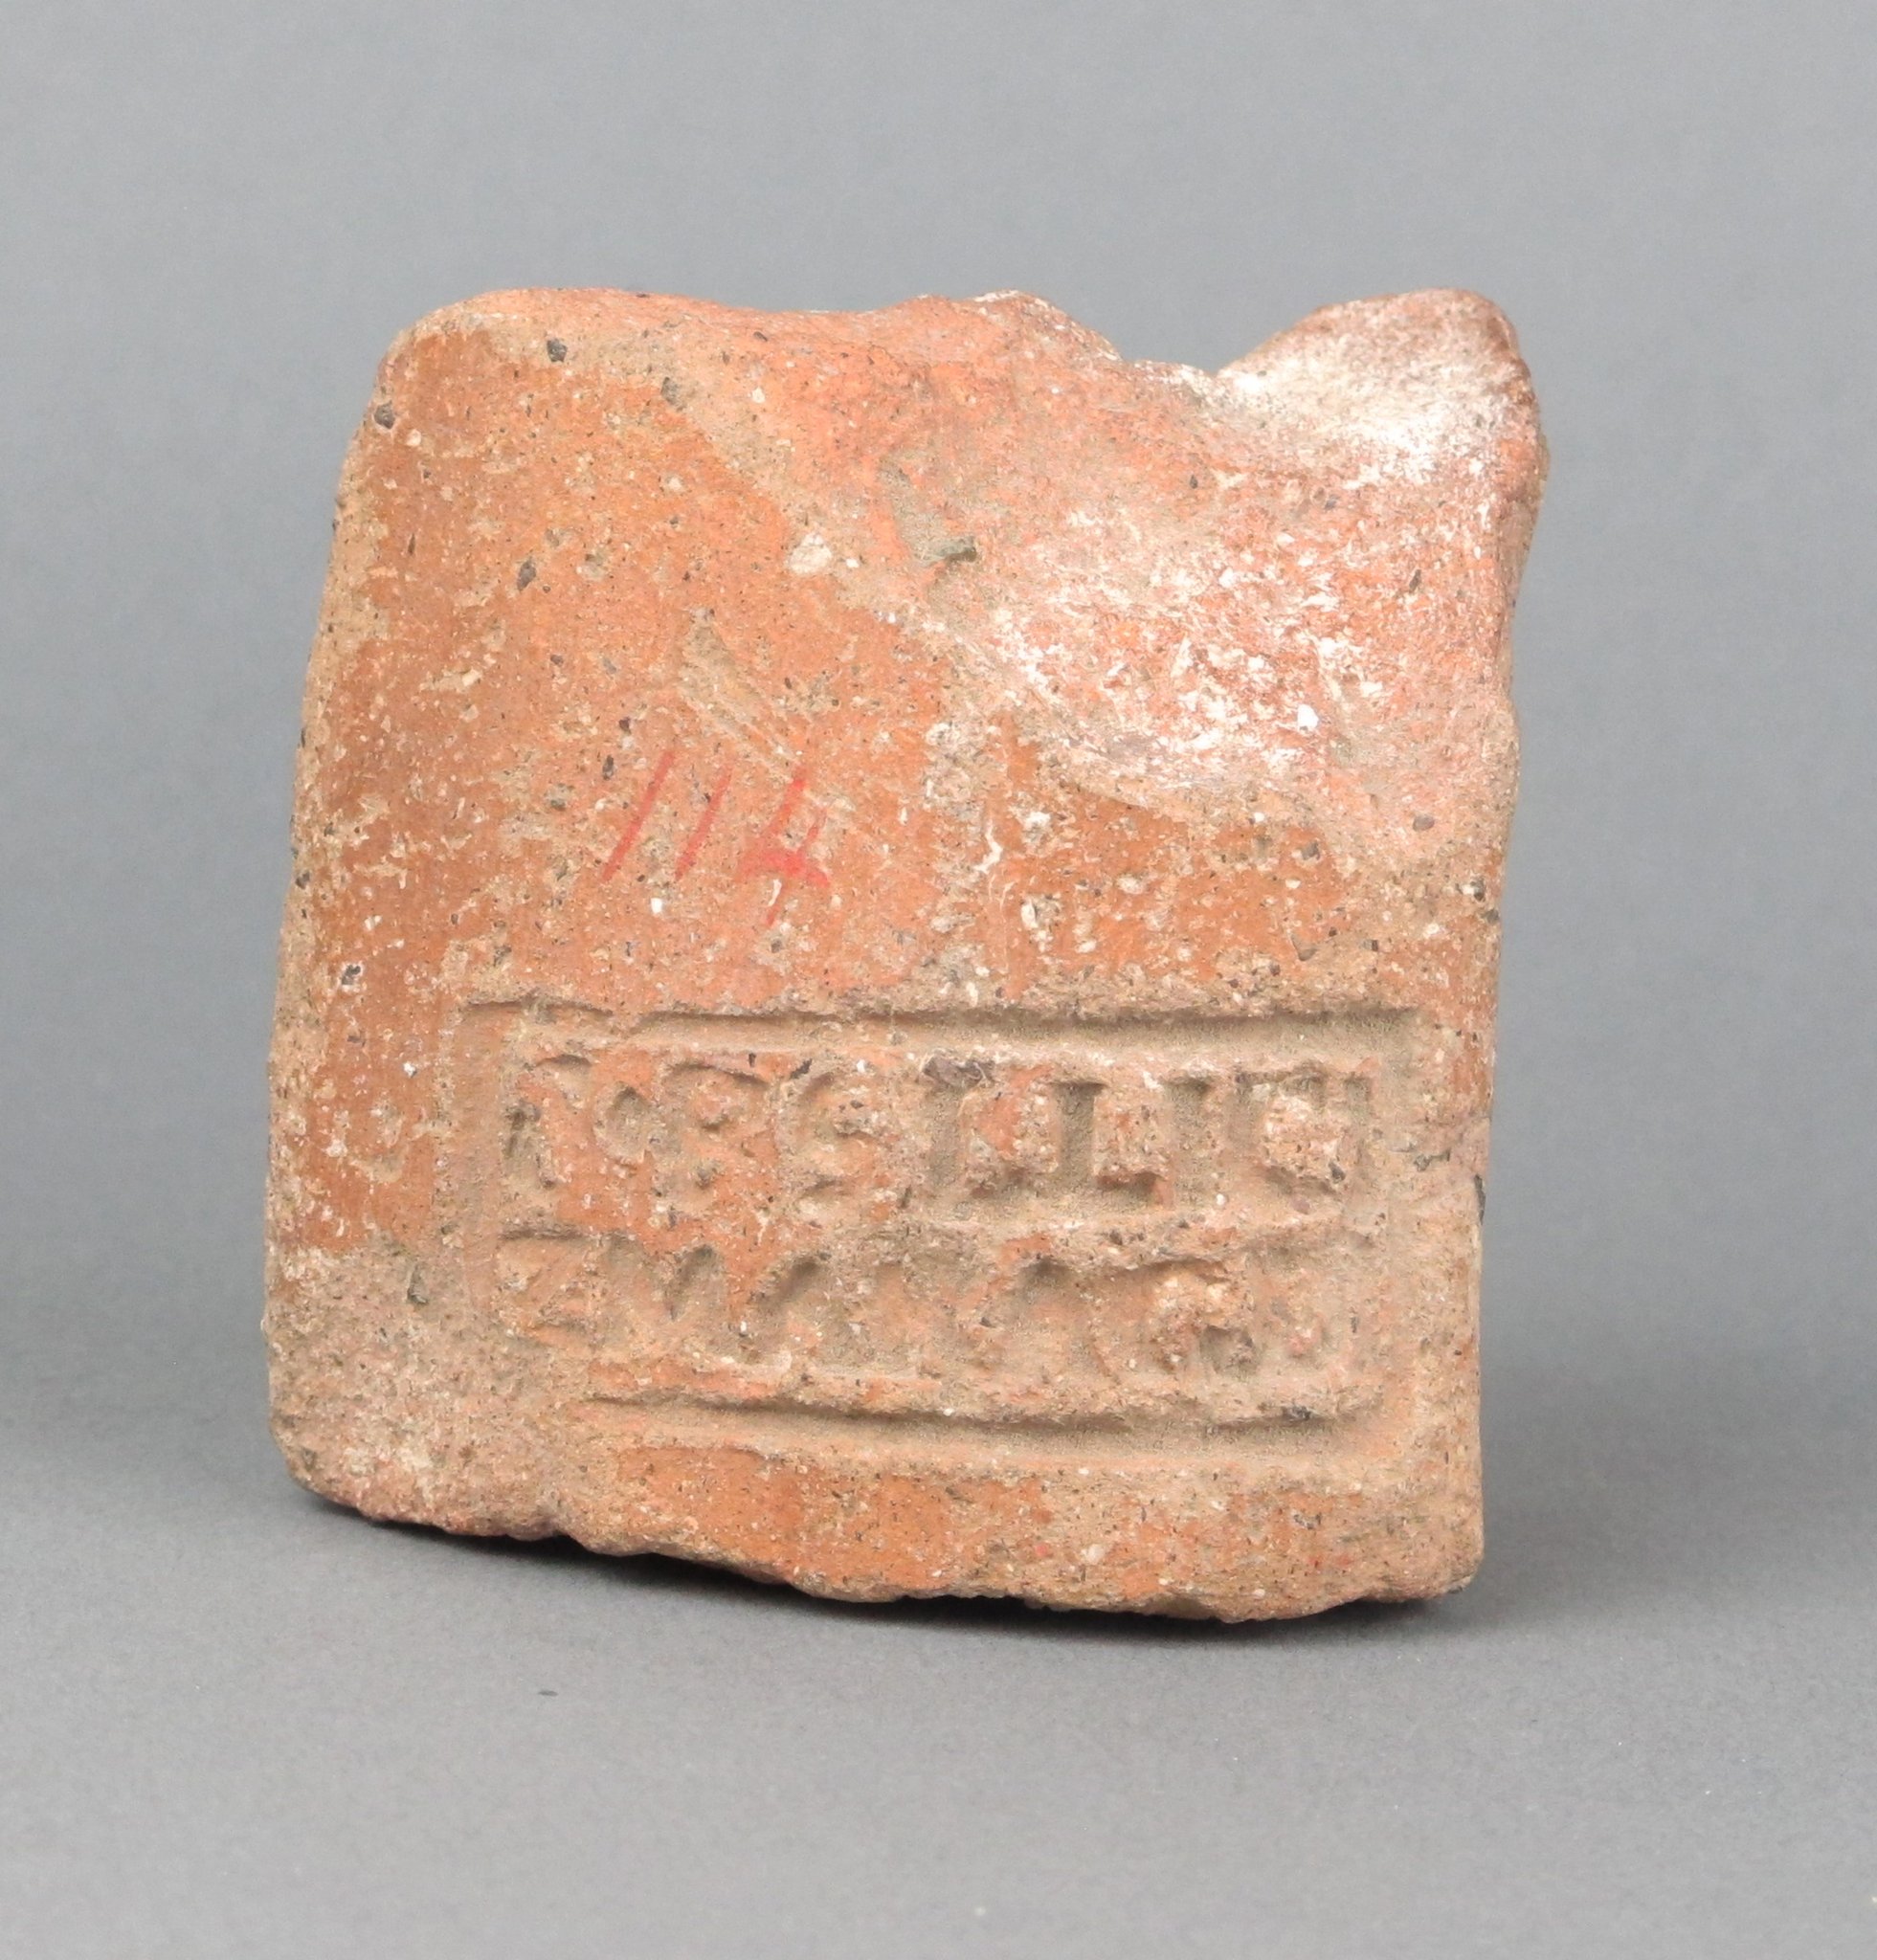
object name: mortarium rim fragment, stamped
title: Terracotta stamped mortarium fragment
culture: roman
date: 267-400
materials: terracotta